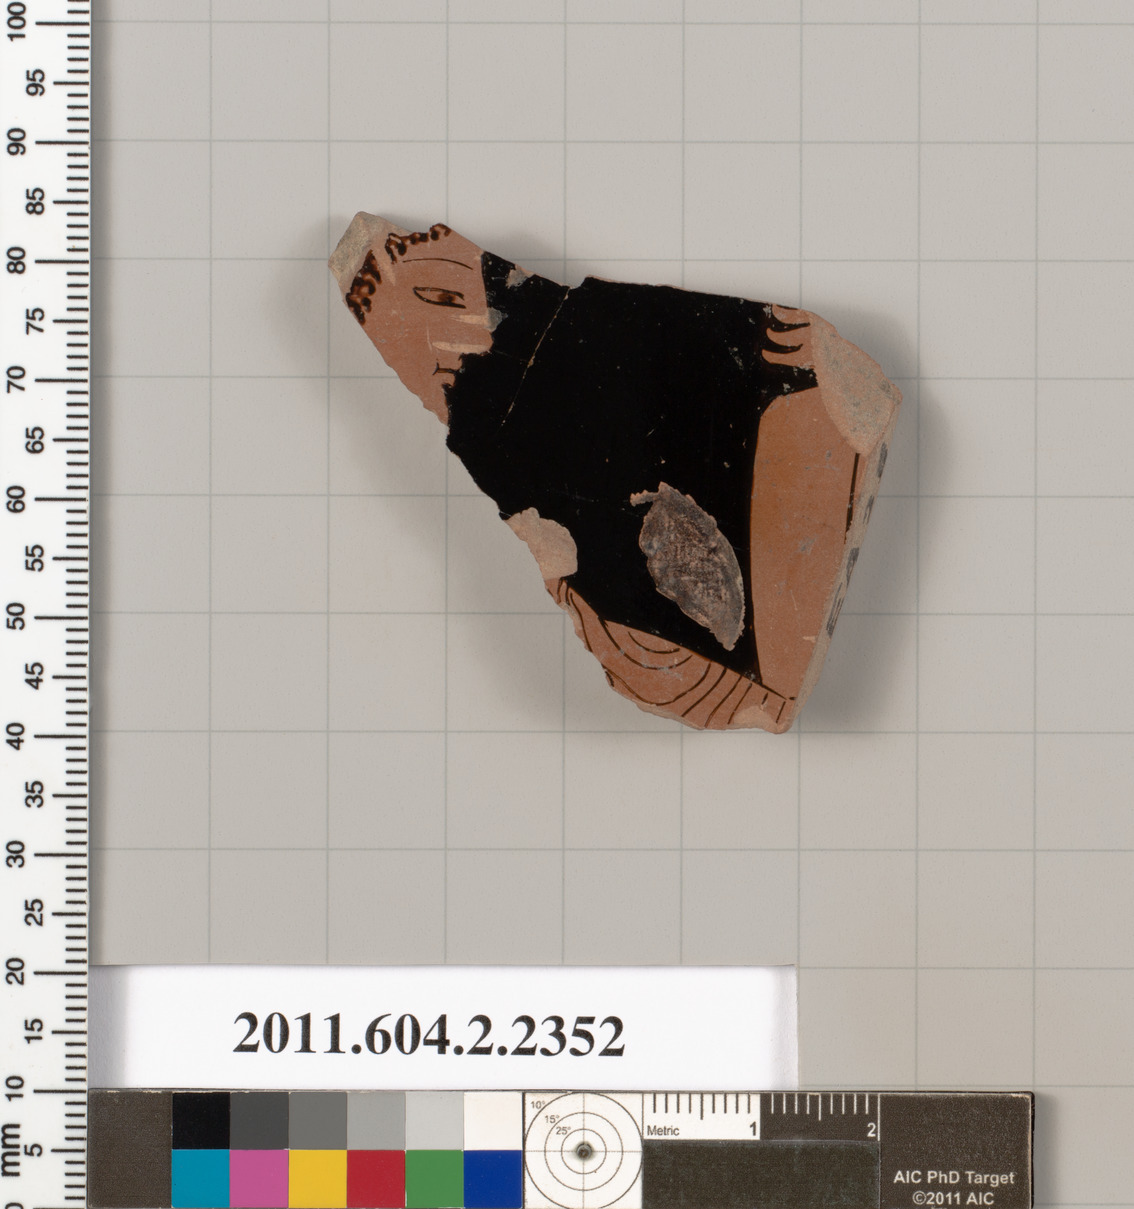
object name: pot fragment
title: Terracotta fragment of a pot; unglazed on the inside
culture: greek, attic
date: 500-490 BCE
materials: terracotta